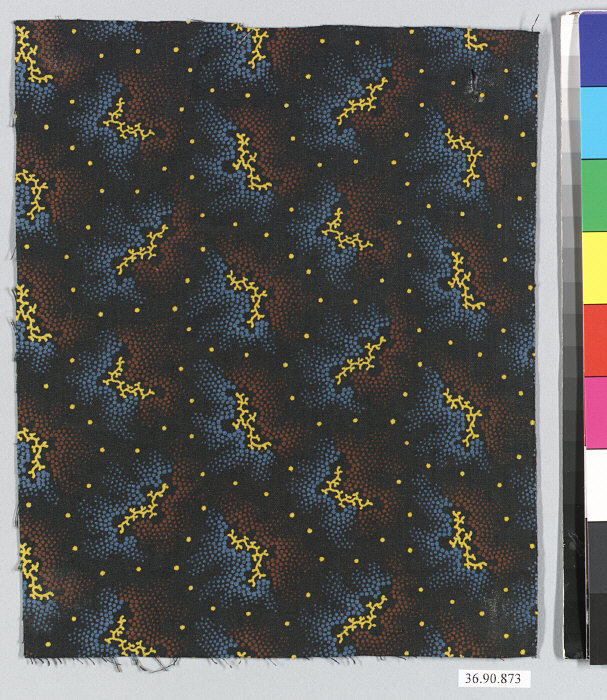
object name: piece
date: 1801-1900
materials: cotton